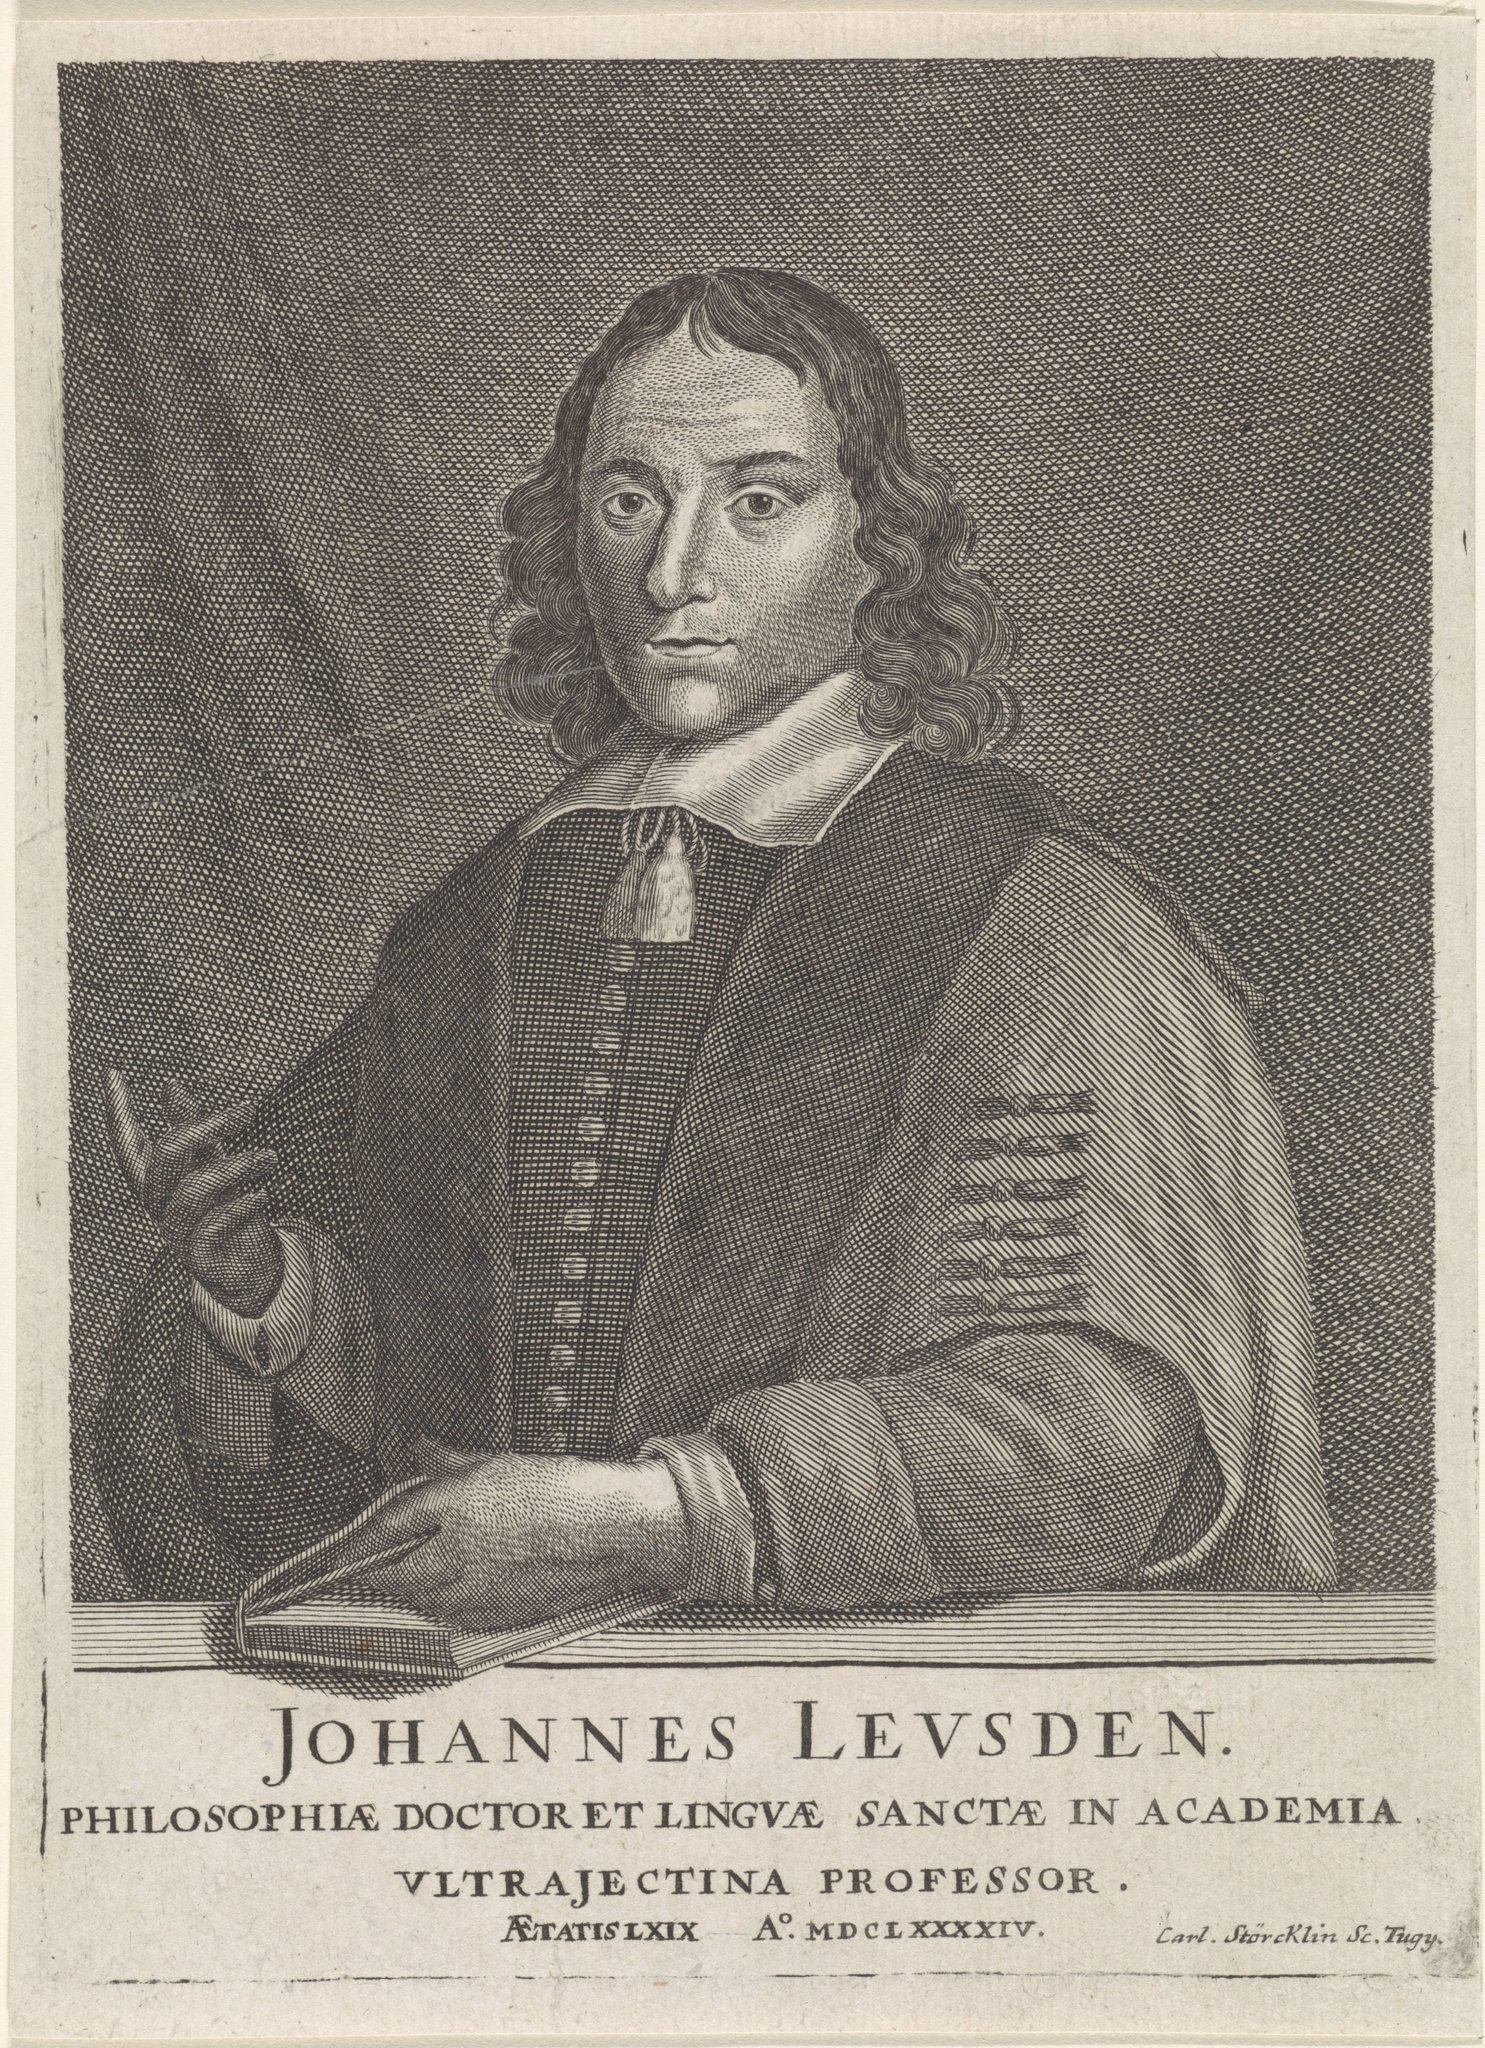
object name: print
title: Portret van Johannes Leusden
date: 1694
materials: paper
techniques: engraving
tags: johannes leusden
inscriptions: collector's mark: Lugt 2228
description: Portret van Johannes Leusden, theoloog en professor te Utrecht op 69-jarige leeftijd. Met zijn rechterhand maakt hij een spreekgebaar.